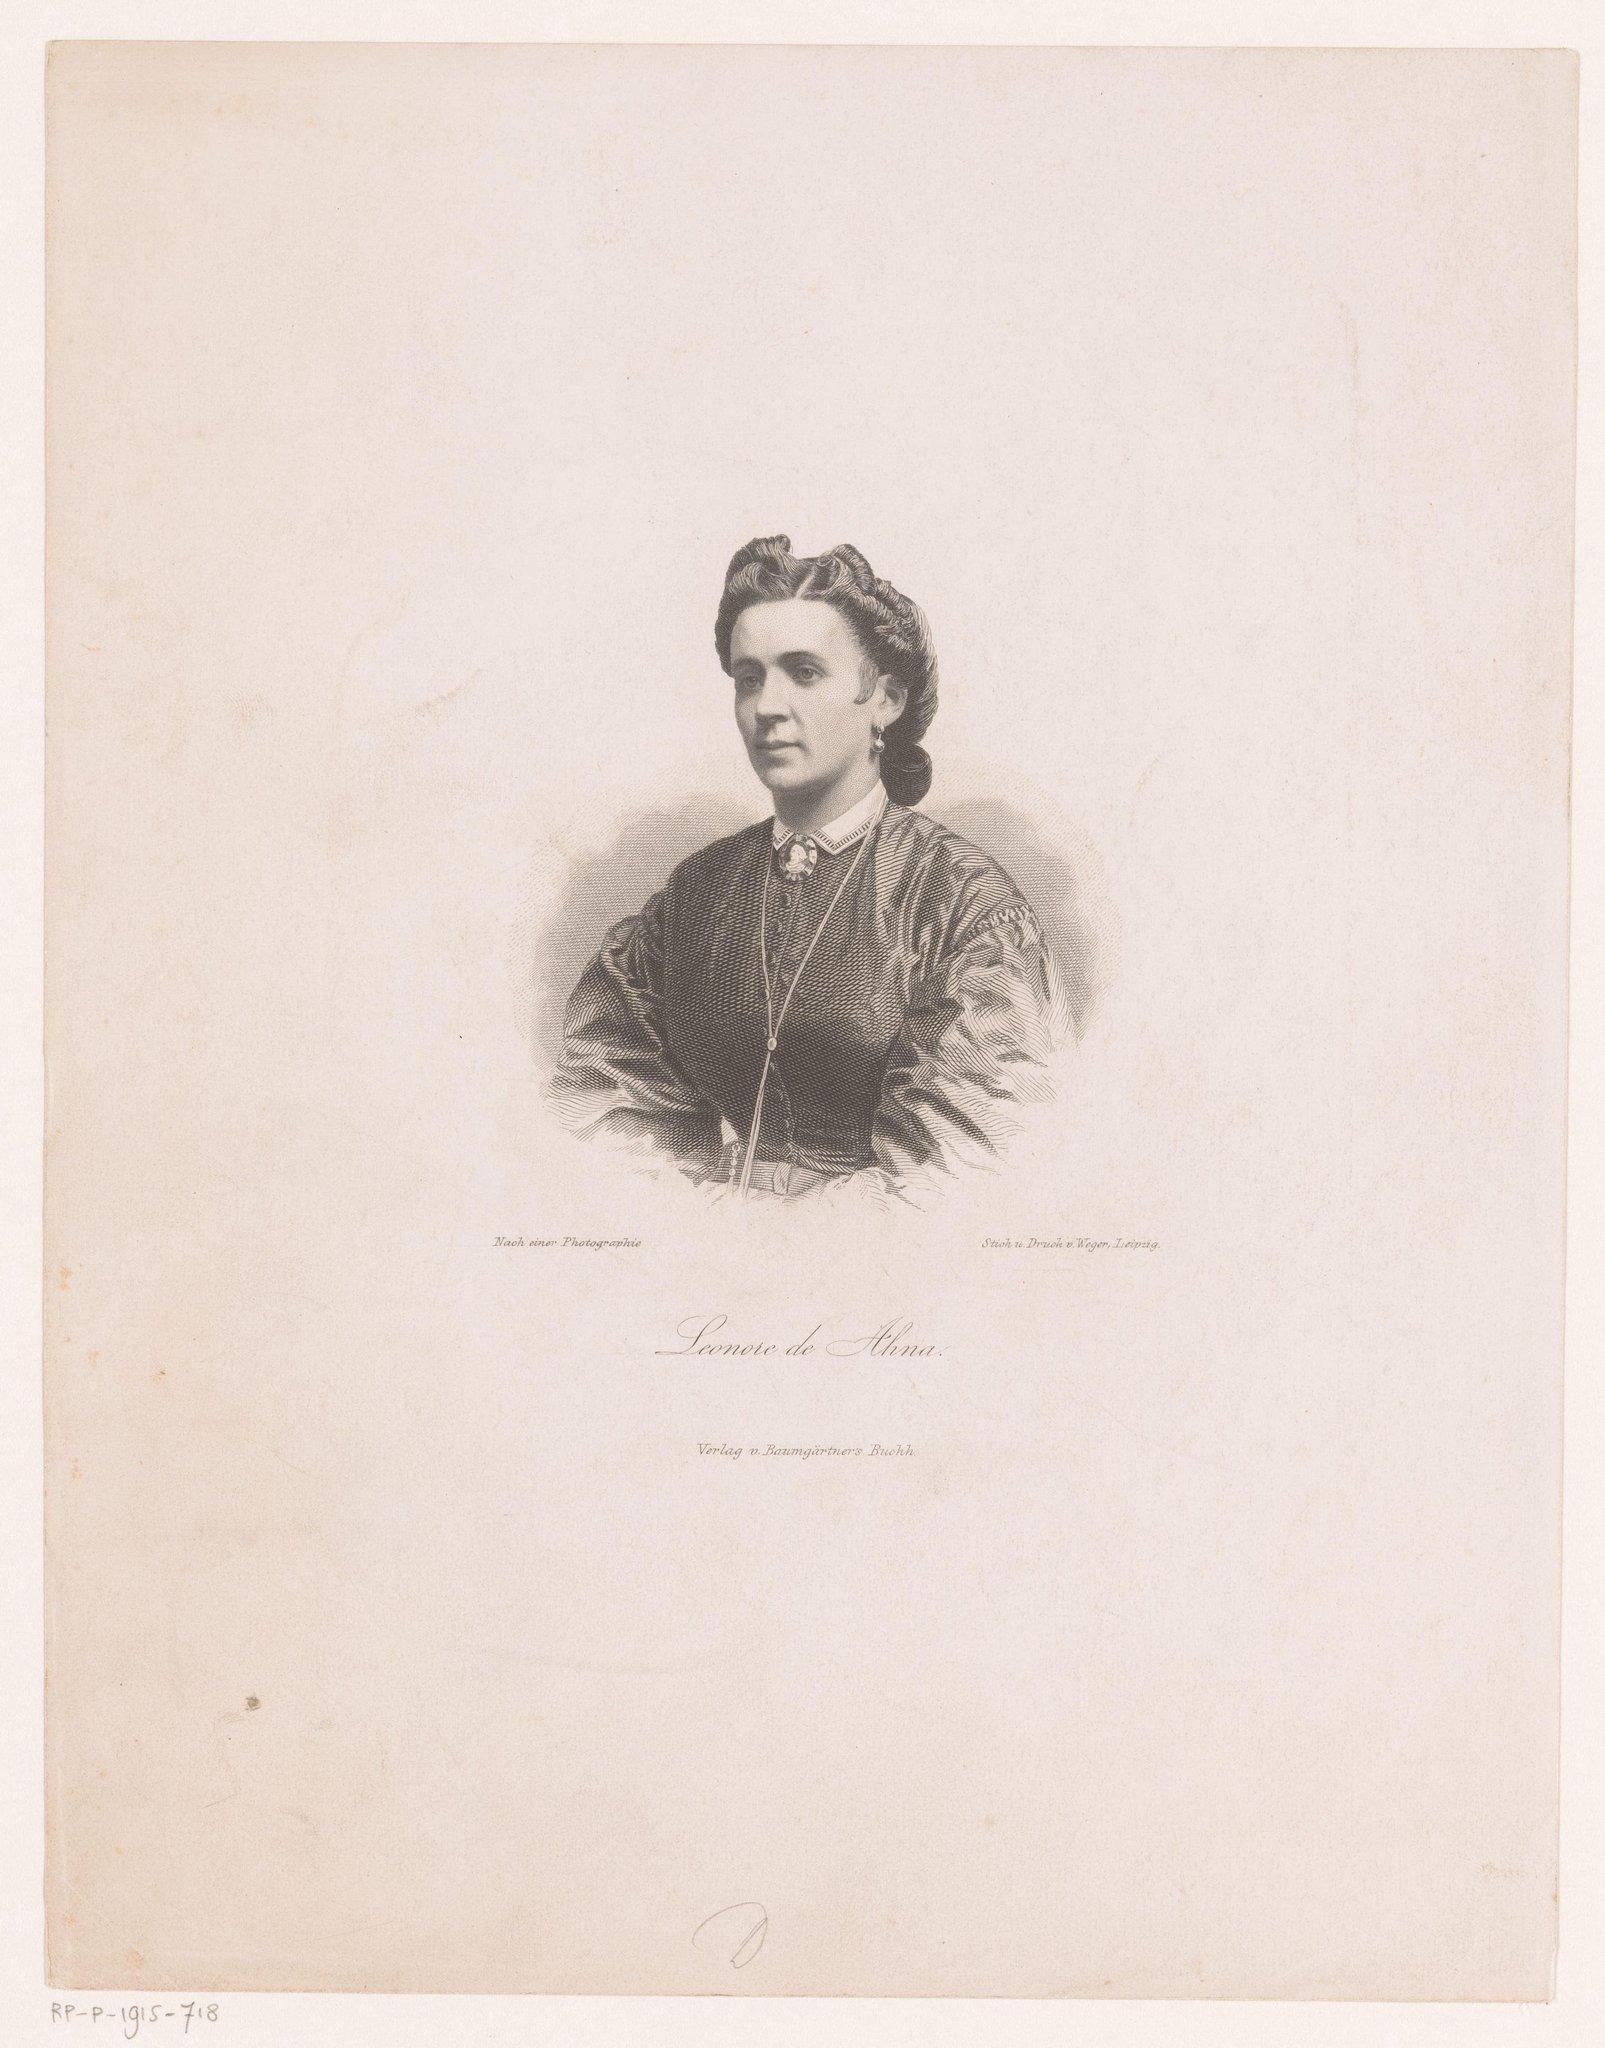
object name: print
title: Portret van Leonore de Ahna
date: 1865-1892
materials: paper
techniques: engraving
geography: leipzig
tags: vienna, berlin, historical persons, portrait of opera-singer, opera-singer (female)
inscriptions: collector's mark: Lugt 2228